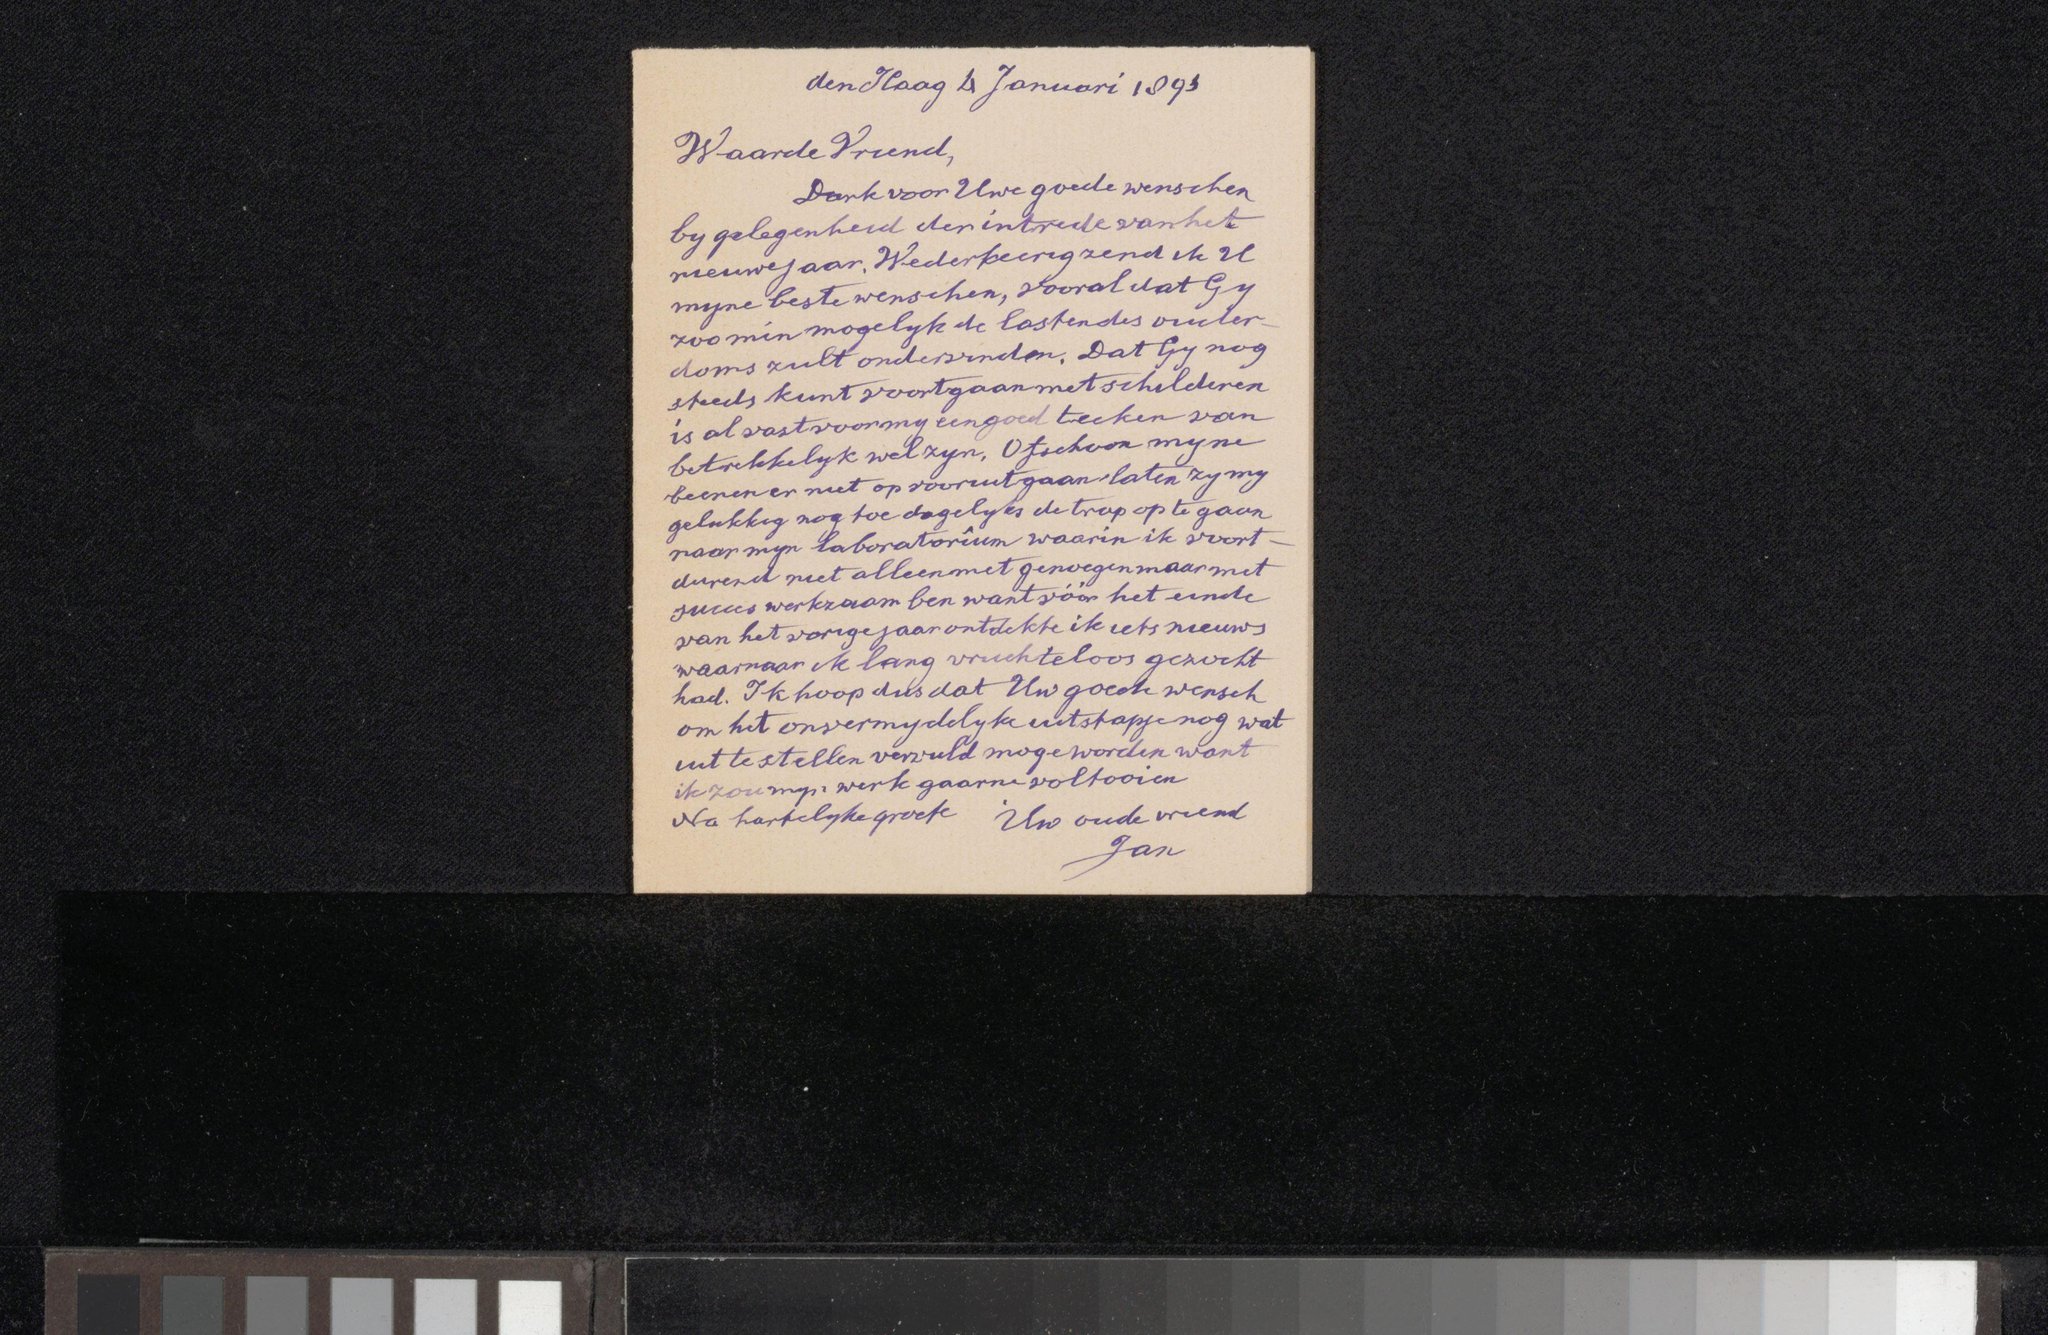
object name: letter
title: Brief aan Ary Johannes Lamme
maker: johan eliza de vrij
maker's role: scheikundige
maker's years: 1813-1898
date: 1893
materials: ink, paper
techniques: pen, writing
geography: the hague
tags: draughtsman, ary johannes lamme, painting (including book-illumination, miniature-painting)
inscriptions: collector's mark: Lugt 2228